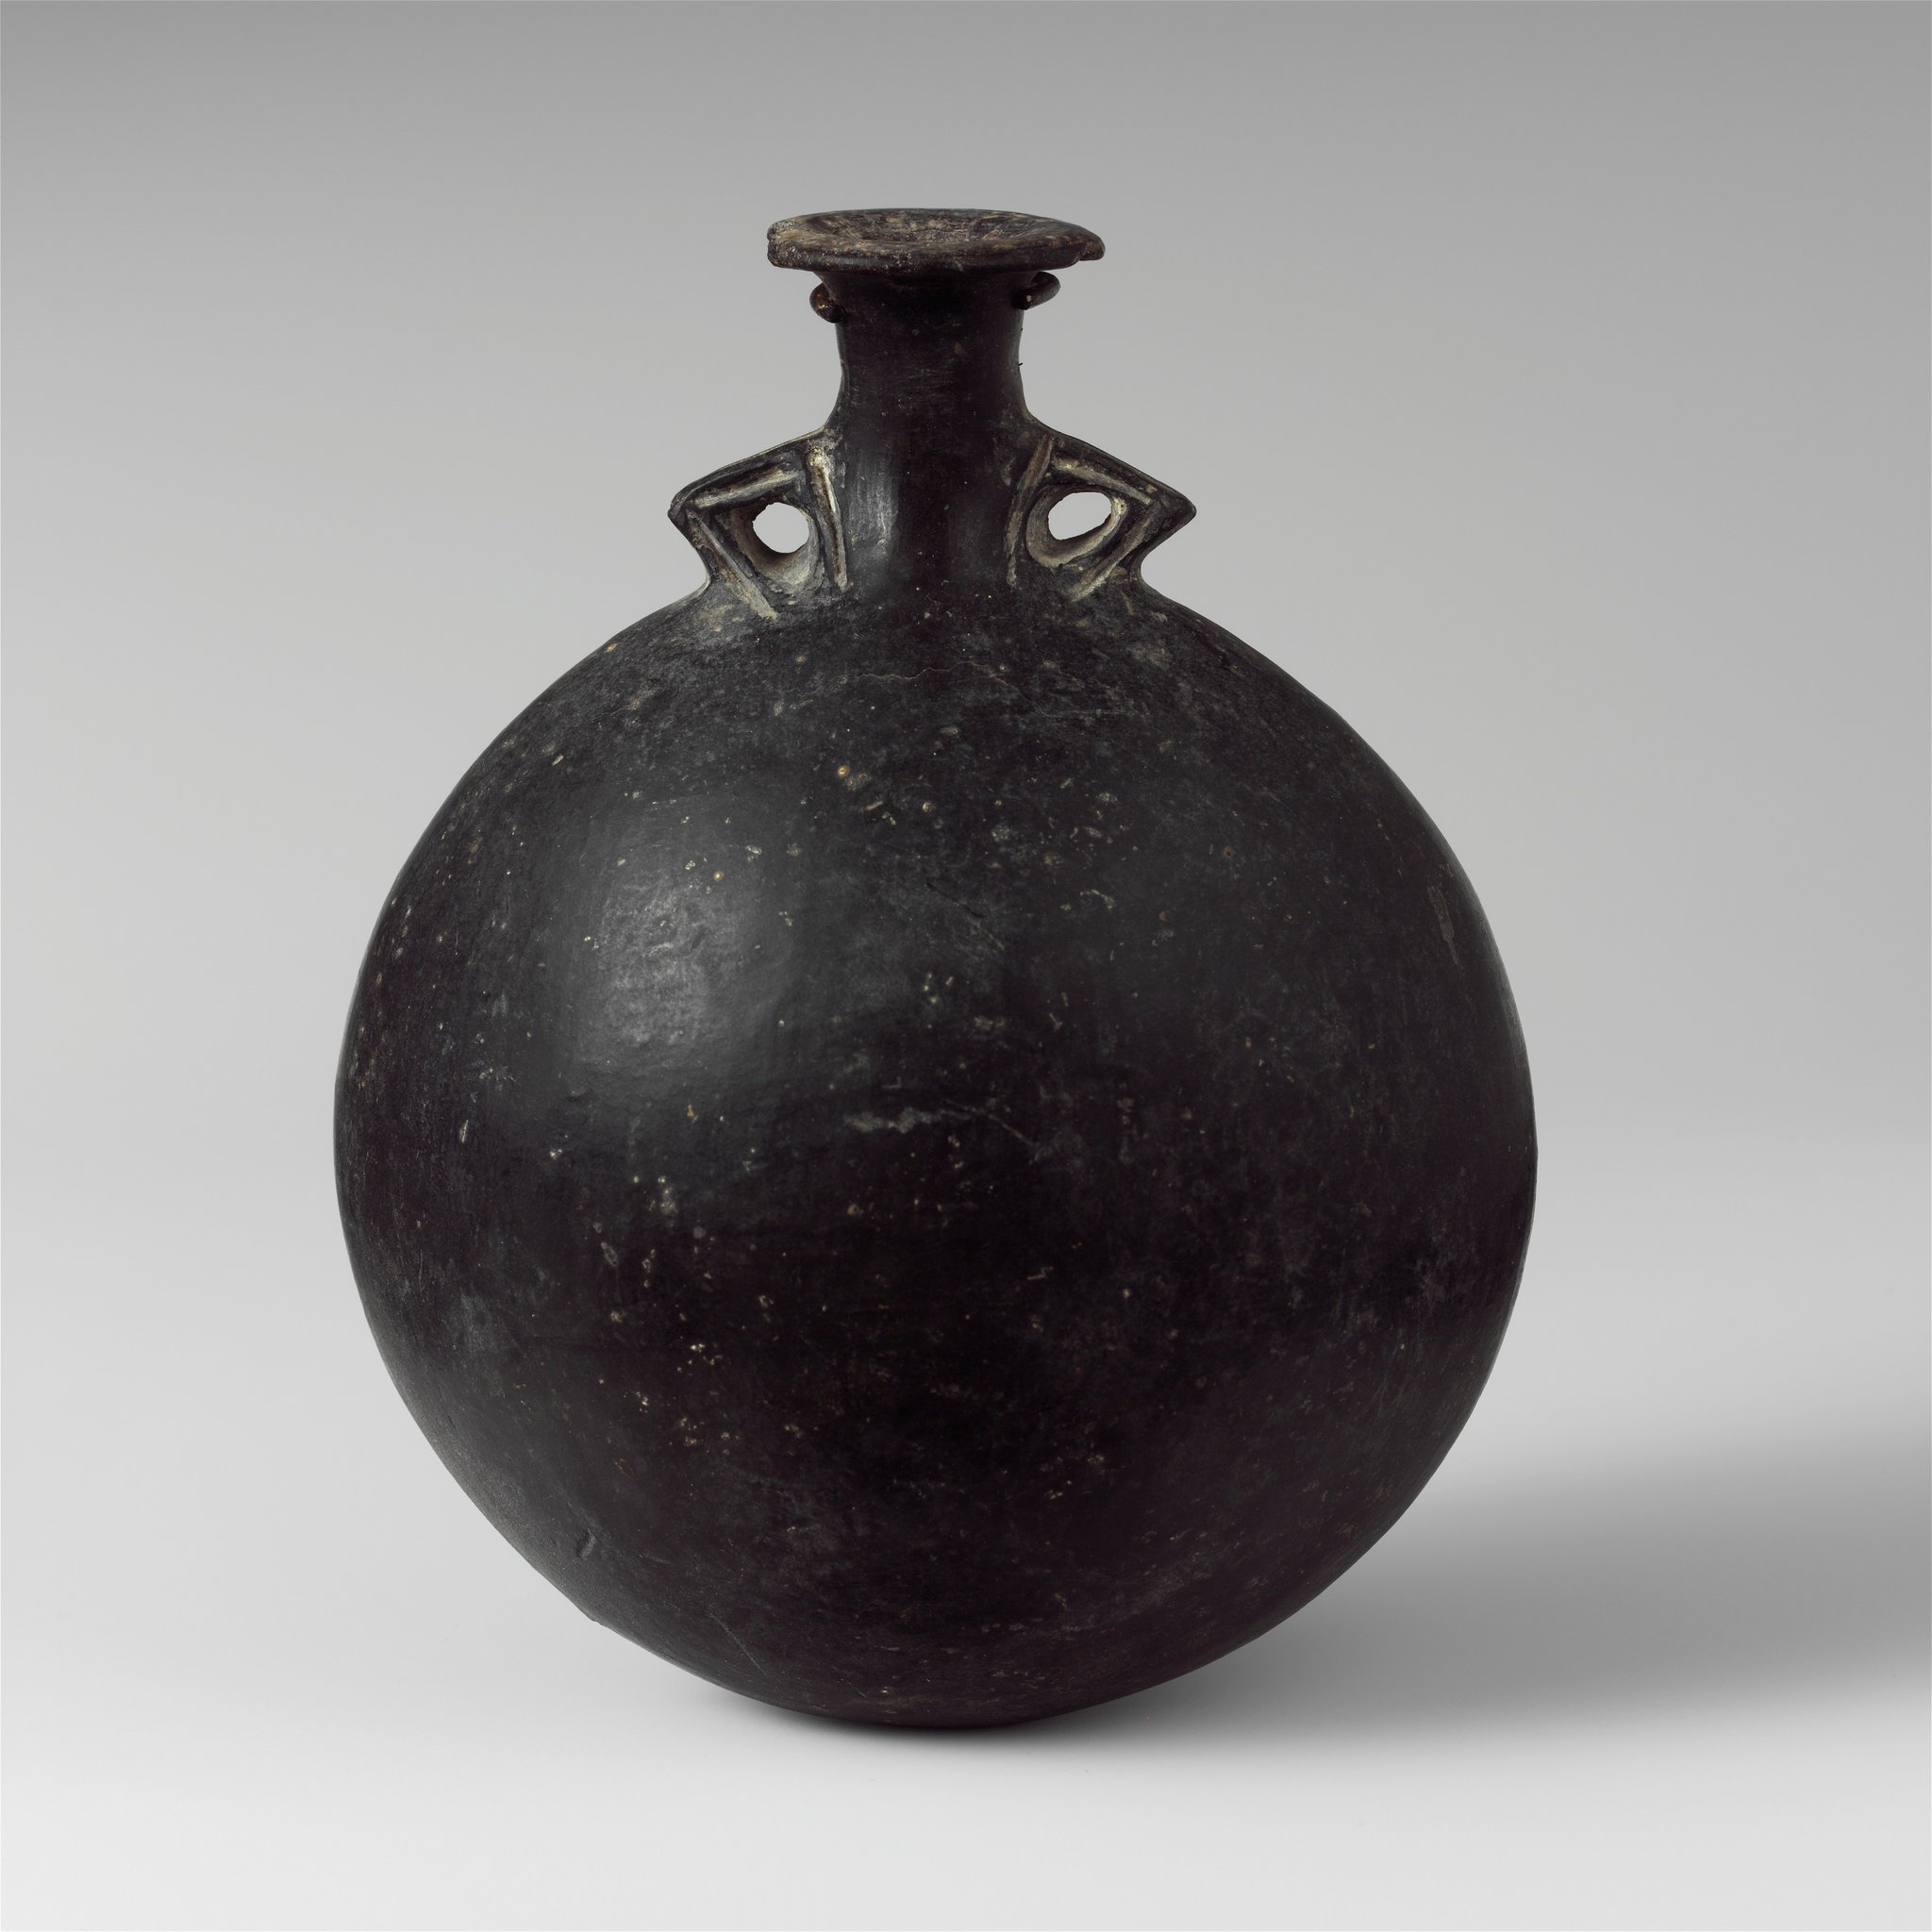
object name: flask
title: Terracotta flask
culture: etruscan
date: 600-501 BCE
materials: terracotta